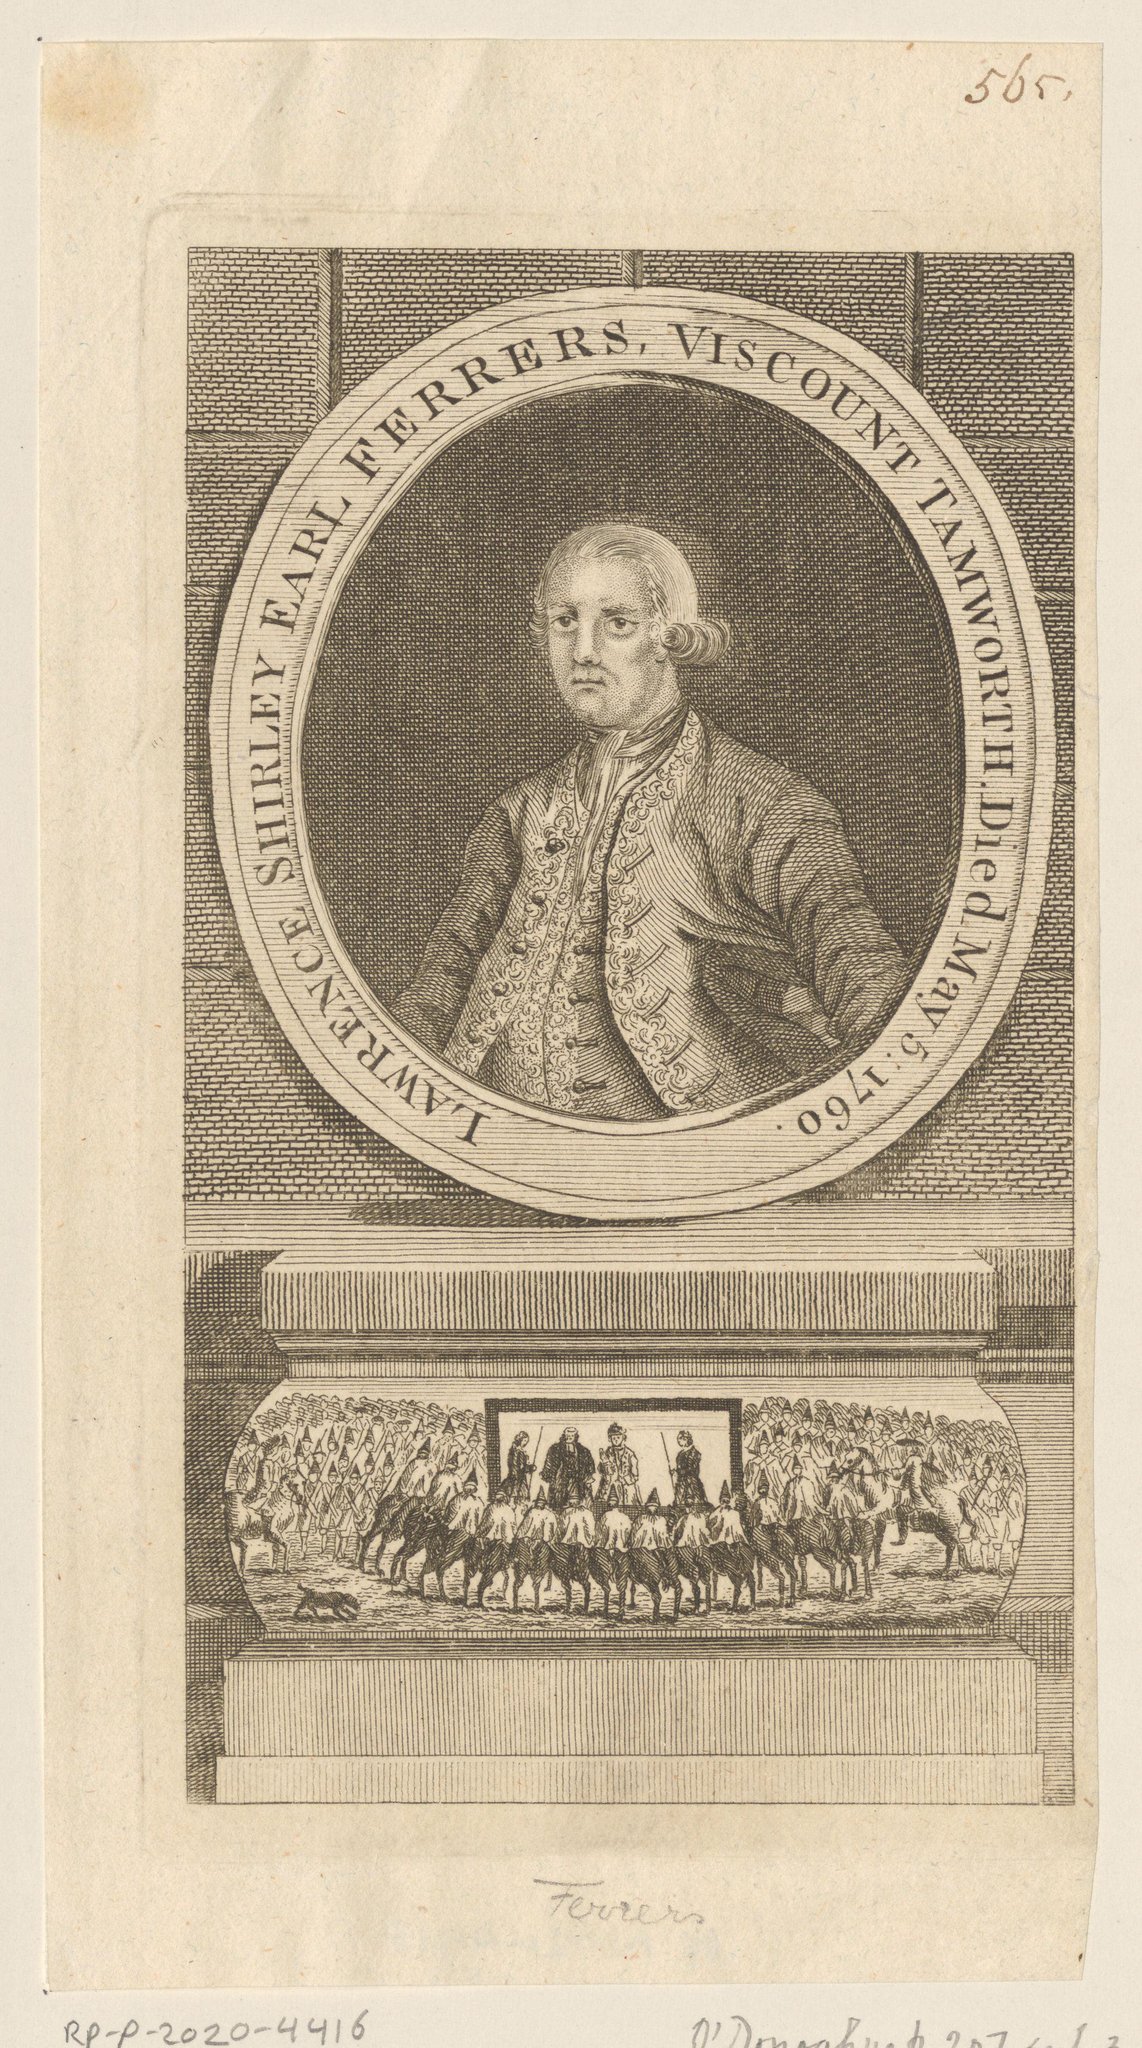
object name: print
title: Portret van Laurence Shirley, 4e graaf Ferrers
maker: Anonymous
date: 1760-1762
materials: paper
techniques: etching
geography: england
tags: historical persons, on the scaffold or place of execution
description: Onder het portret een voorstelling van zijn executie op 5 mei 1760.